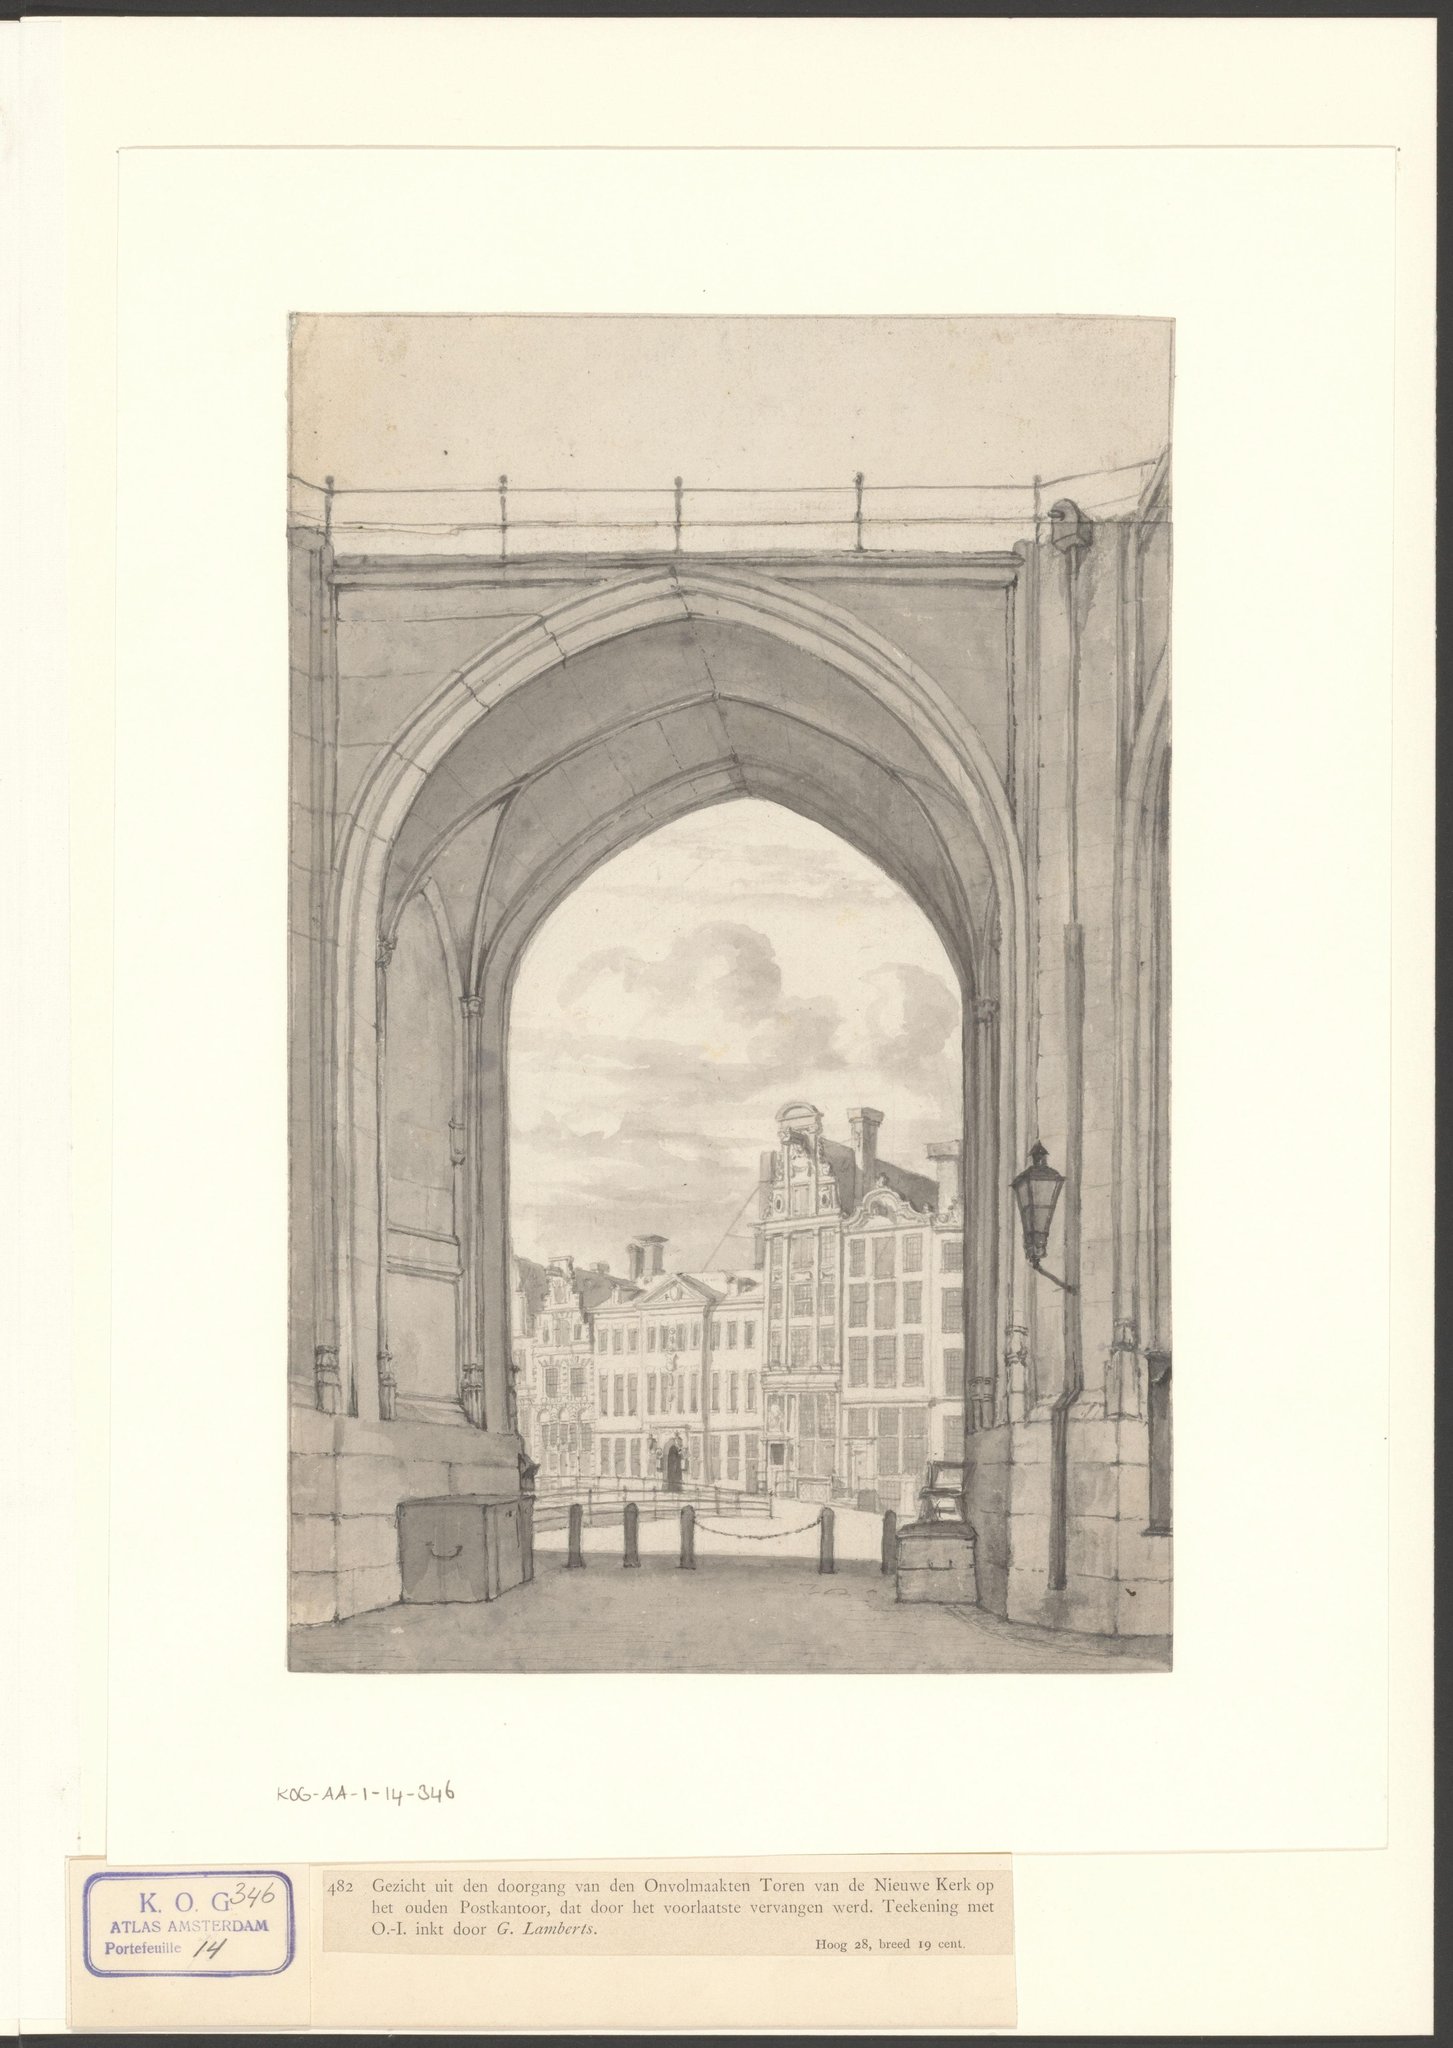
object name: drawing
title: Gezicht vanuit de onvoltooide toren van de Nieuwe Kerk naar de Nieuwezijds Voorburgwal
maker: gerrit lamberts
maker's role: bookseller, draughtsman, print maker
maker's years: 1776-1850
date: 1786-1850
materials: ink, paper, pencil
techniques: brush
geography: amsterdam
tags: city-view in general; 'veduta', the usual house or row of houses, passage, street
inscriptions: collector's mark: ‘14’ Lugt 1641b, inscription: ‘482 Gezicht uit (...) breed 19 cent.’, inscription: ‘Port. 14-346’, inscription: ‘ams[...]’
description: Onderwerpsrubriek binnen de Atlas Amsterdam: Verhulststraat (Johannes), Viaducten, Vierwindenstraat, Vinkenbuurt, Vinkenpad, Vinkenstraat, Vischsteeg, Vliegendesteeg, Voetboogstraat, Volewijk, Vondelstraat, Voorburgwal (N.Z.).